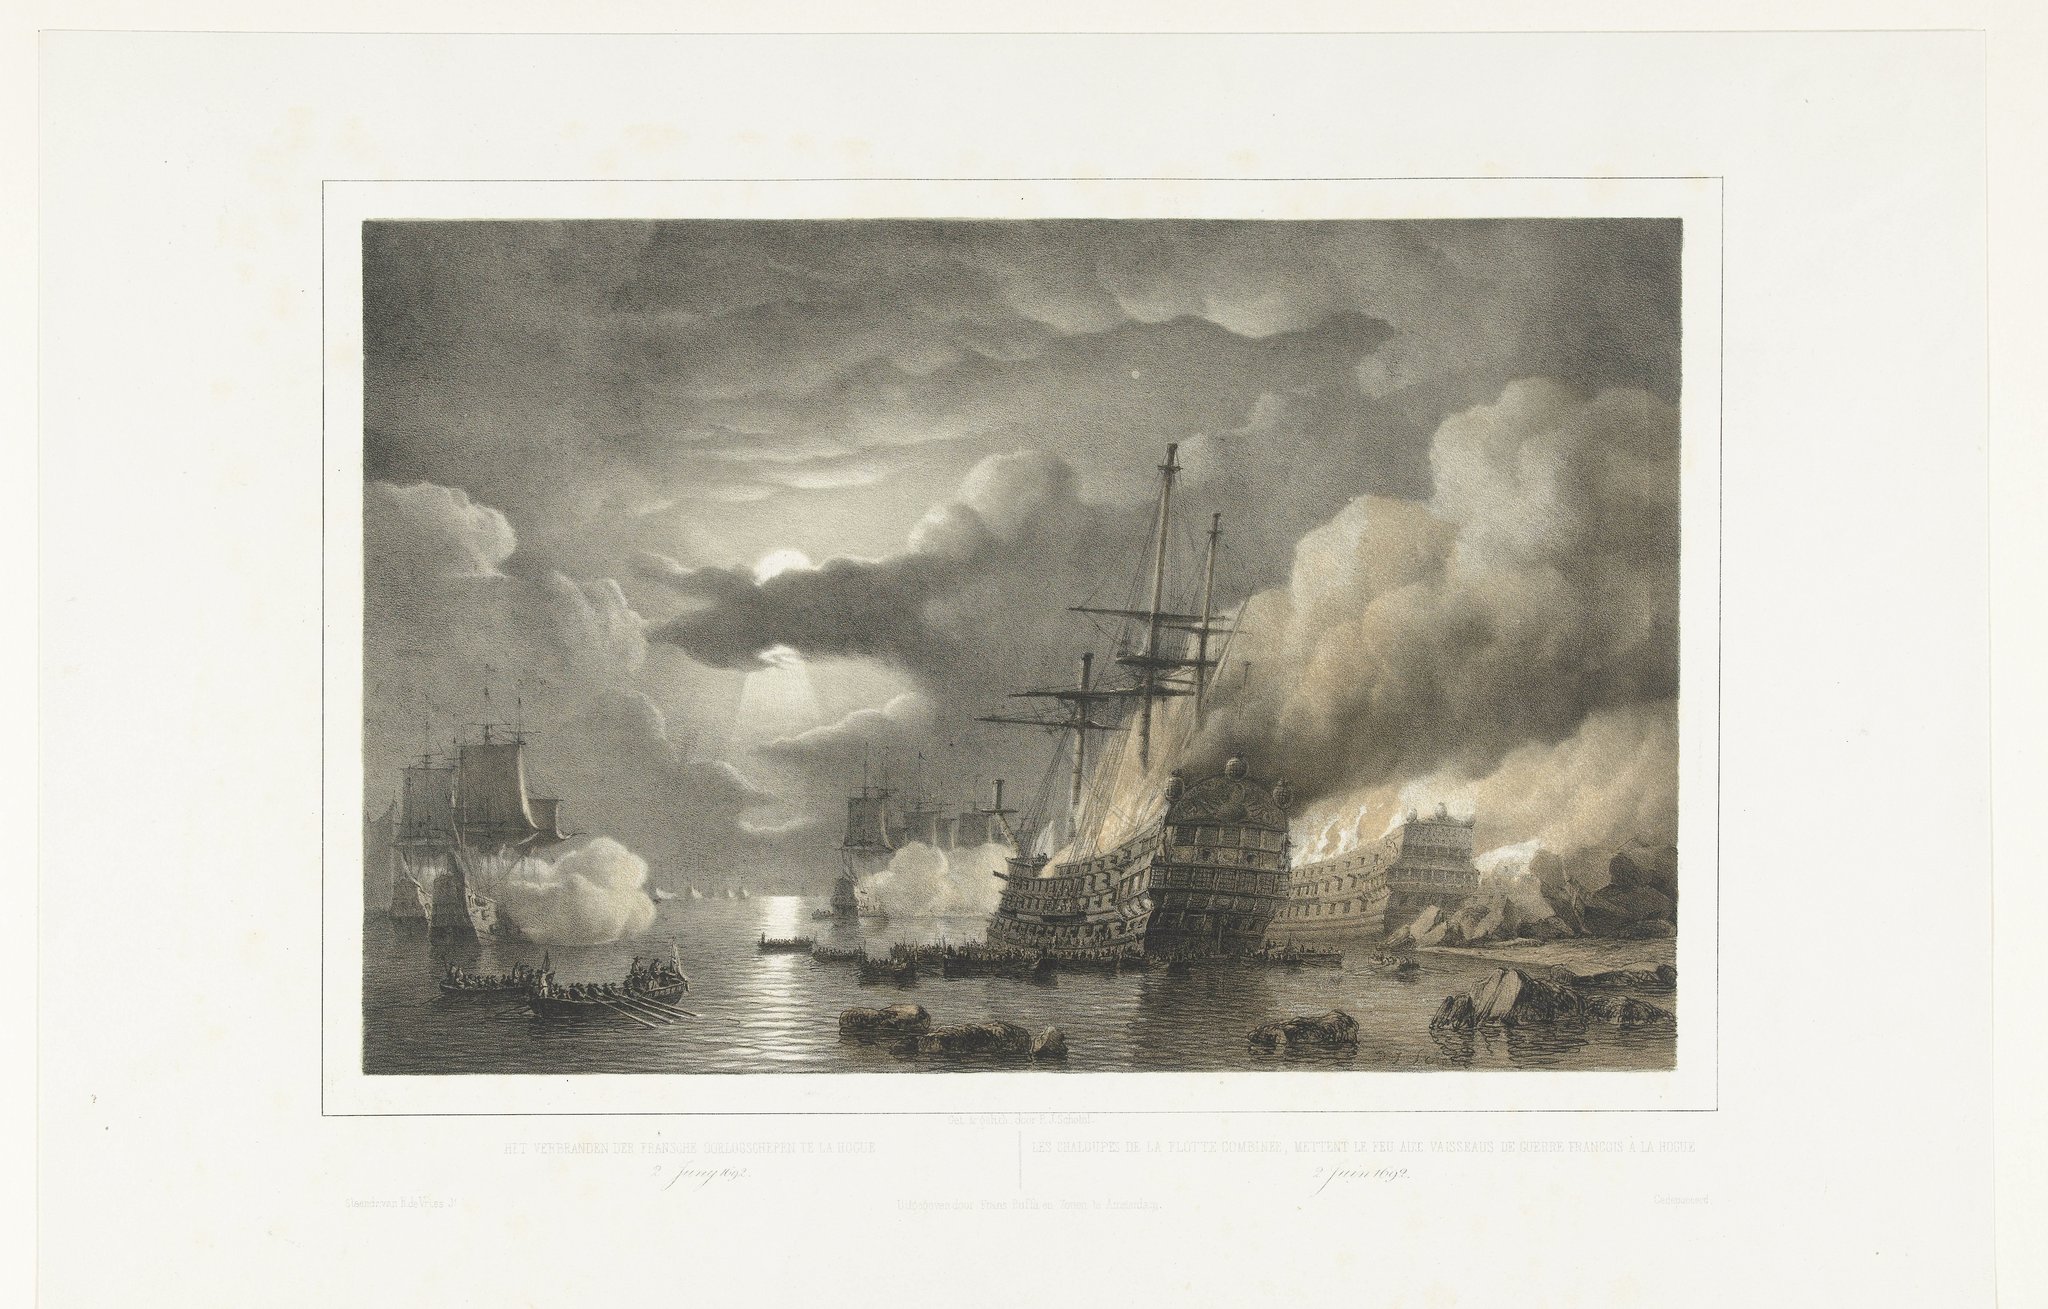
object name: print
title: Het verbranden der Fransche oorlogschepen te La Hogue 2 Juny 1692 / Les chaloupes de la flotte combinée, mettent le feu aux vaisseaus de guerre Francois à La Hogue 2 Juin 1692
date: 1848-1855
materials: paper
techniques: lithograph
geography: amsterdam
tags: paris, battle (+ naval force)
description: Uitgegeven in: P.J. Schotel, Heldendaden der Nederlanders ter zee, van de vroegste tijden tot op heden, naar aanleiding van de: Geschiedenis van het Nederlandsche zeewezen, Frans Buffa en Zonen, Amsterdam 1850-1855, pl. 37. Zonder de bij Muller vermelde bijgevoegde uitvoerige beschrijving.